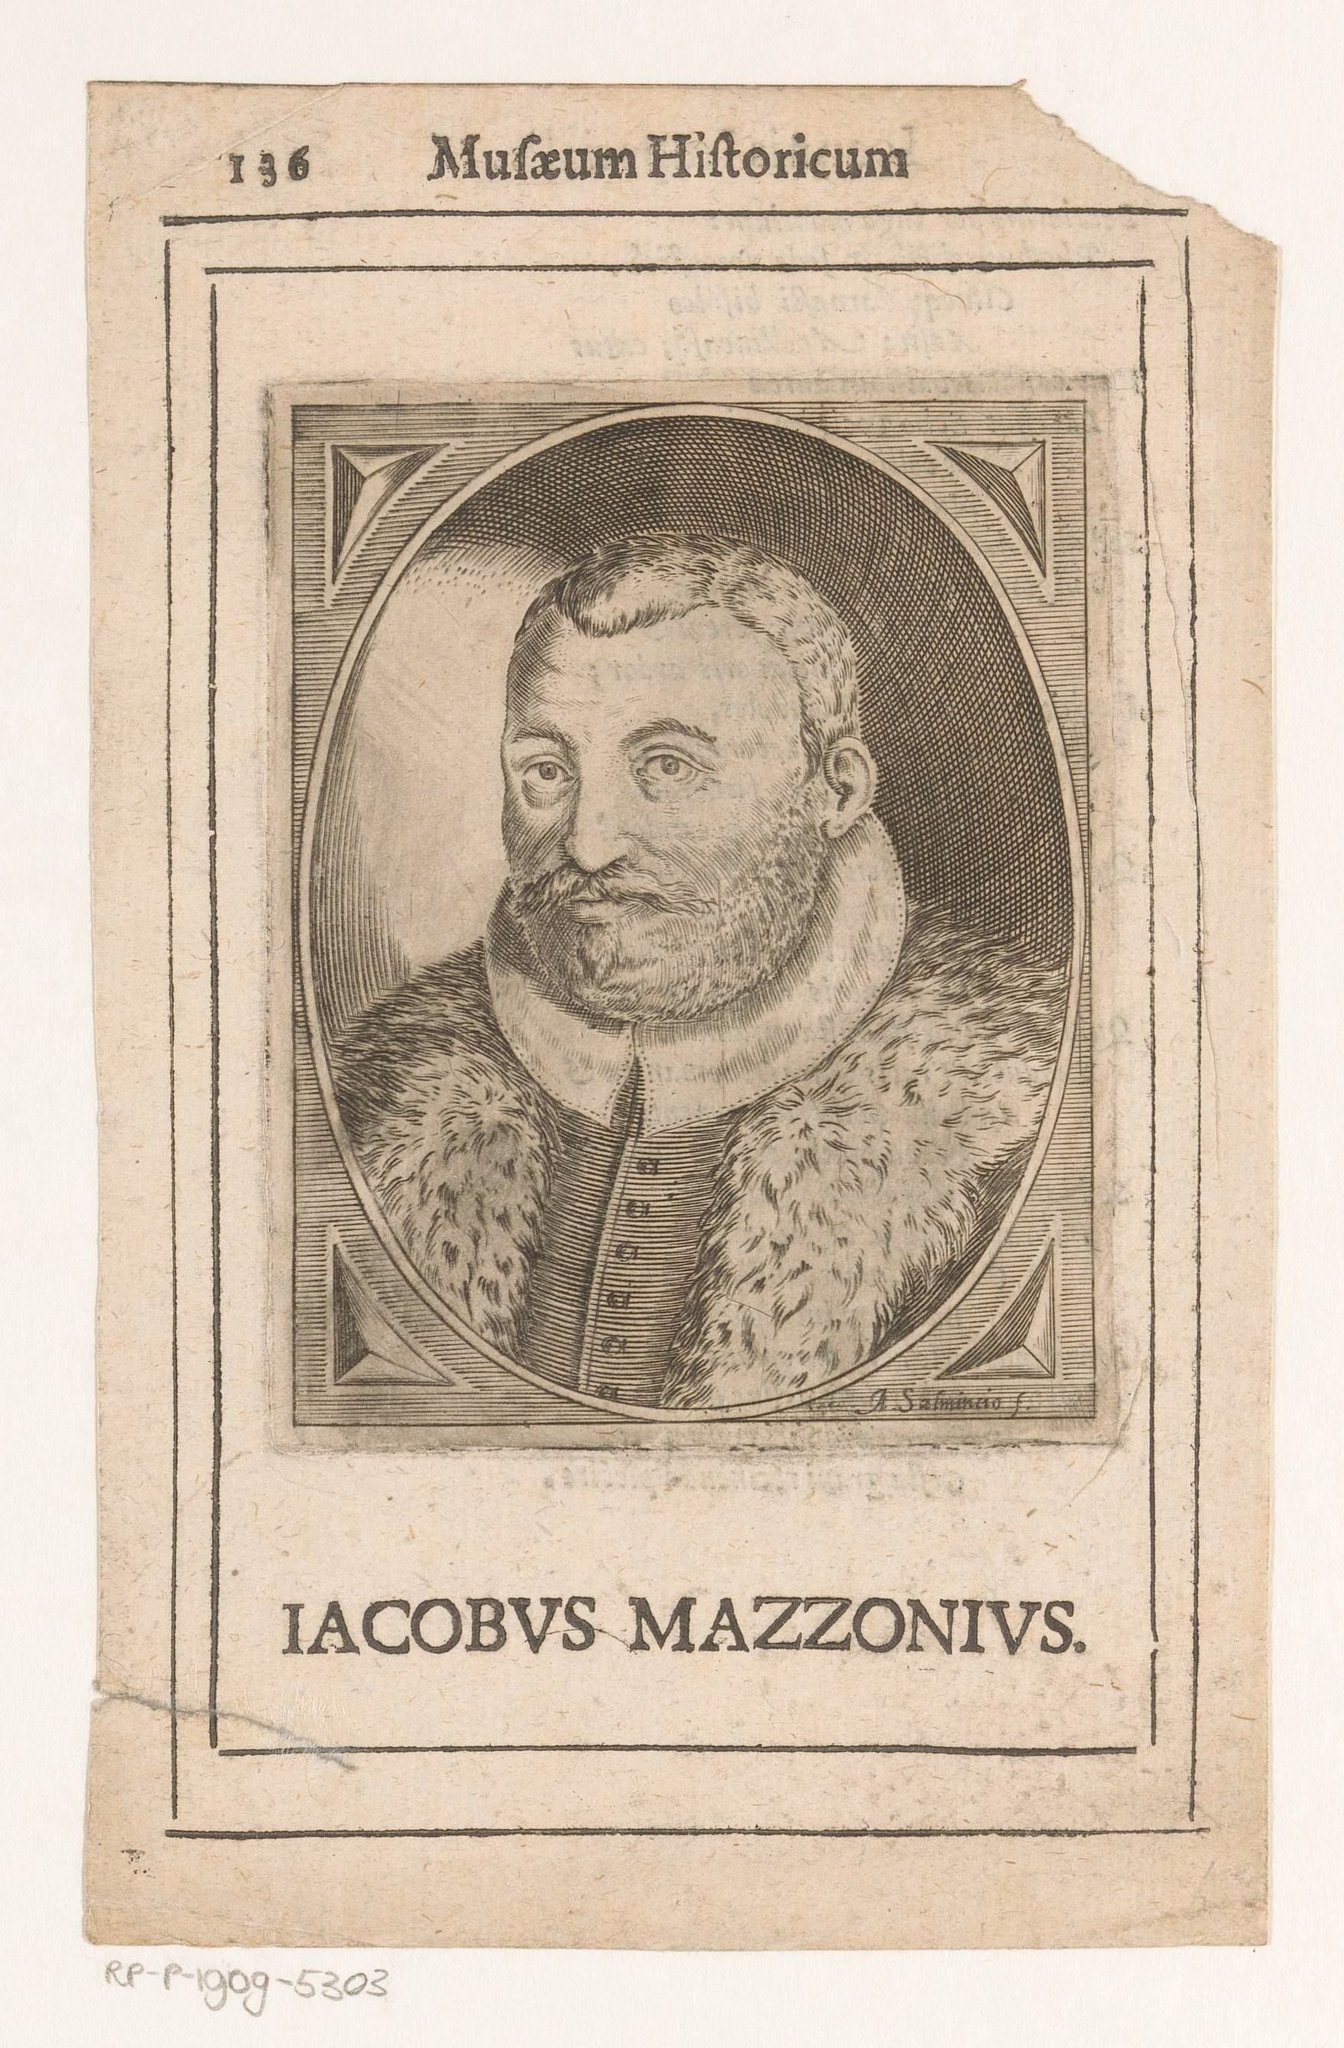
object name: book illustration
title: Portret van geschiedschrijver Francesco Guicciardini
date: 1640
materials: paper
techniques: engraving, letterpress printing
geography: venice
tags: politician, historical persons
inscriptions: collector's mark: Lugt 2228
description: Prent uit: Imperiali, Giovanni. Musaeum historicum et physicum ... In primo illustrium literis virorum imagines ad vivum expressȩ continentur, additis elogiis ... In secundo animorum imagines, sive ingeniorum naturȩ, differentiȩ, causȩ, ac signa physice perpenduntur .... Venetië: Apud Juntas, 1640.